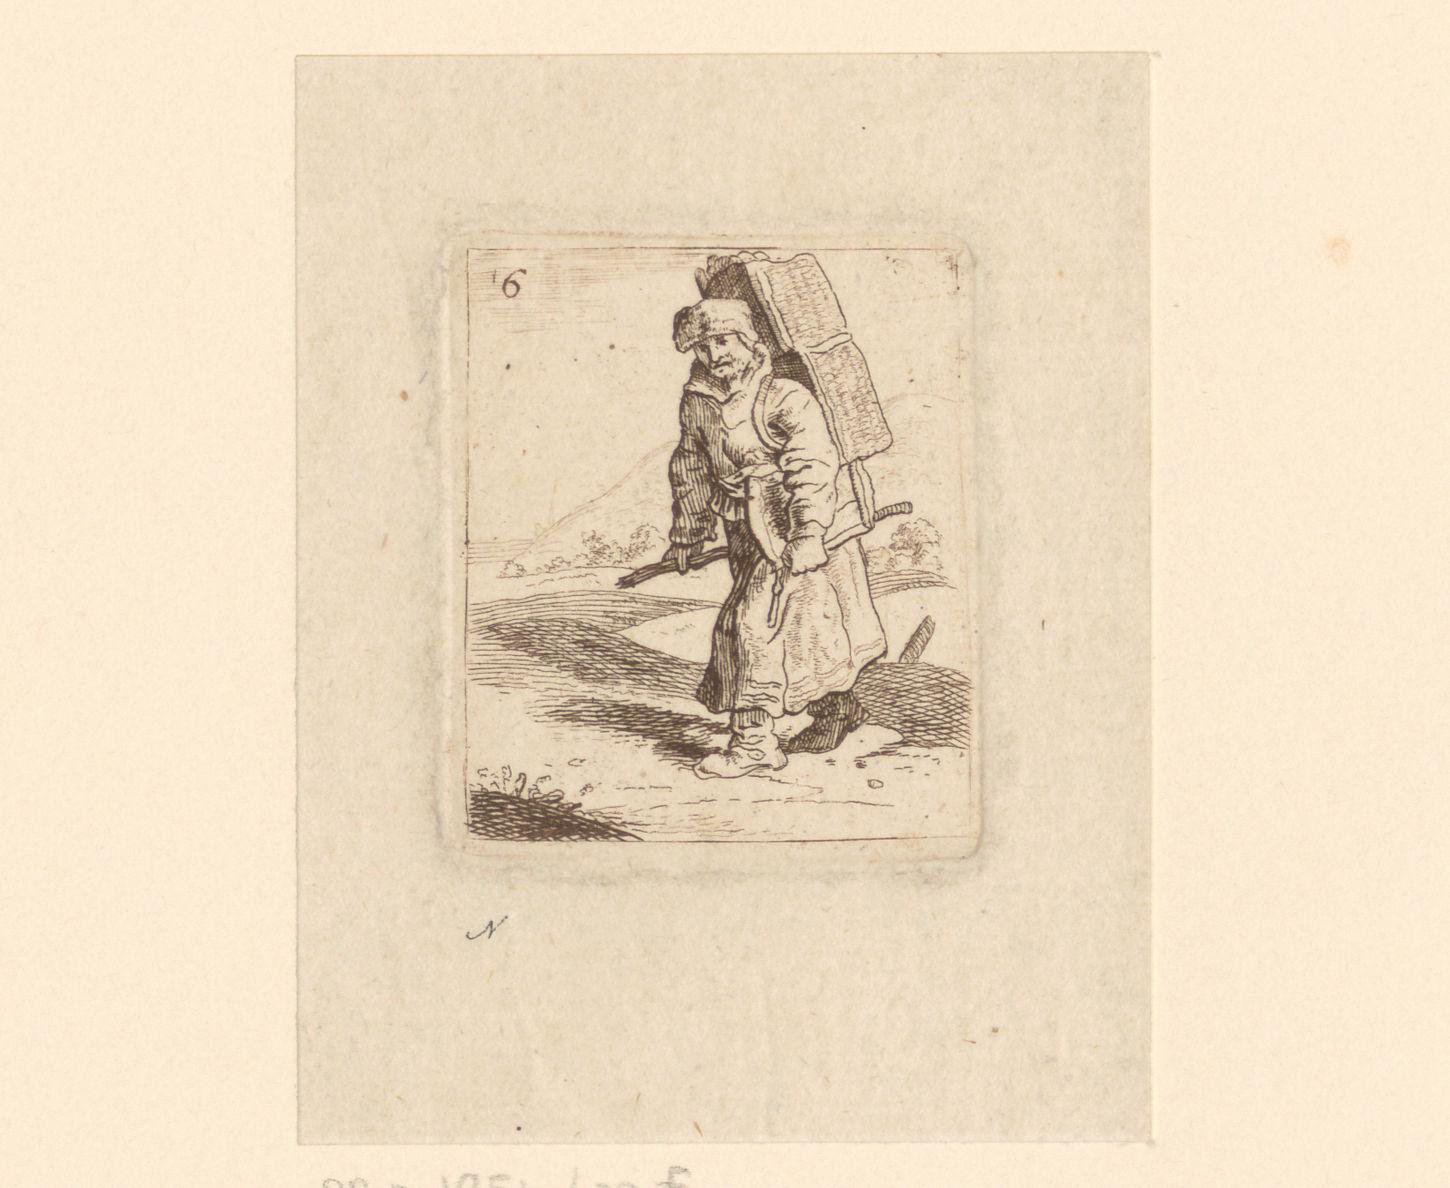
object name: print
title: Figuren met verschillende beroepen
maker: paul sandby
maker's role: draughtsman, print maker, publisher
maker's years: 1725-1809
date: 1735-1809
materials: paper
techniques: etching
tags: containers, adult man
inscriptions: collector's mark: Lugt 2228